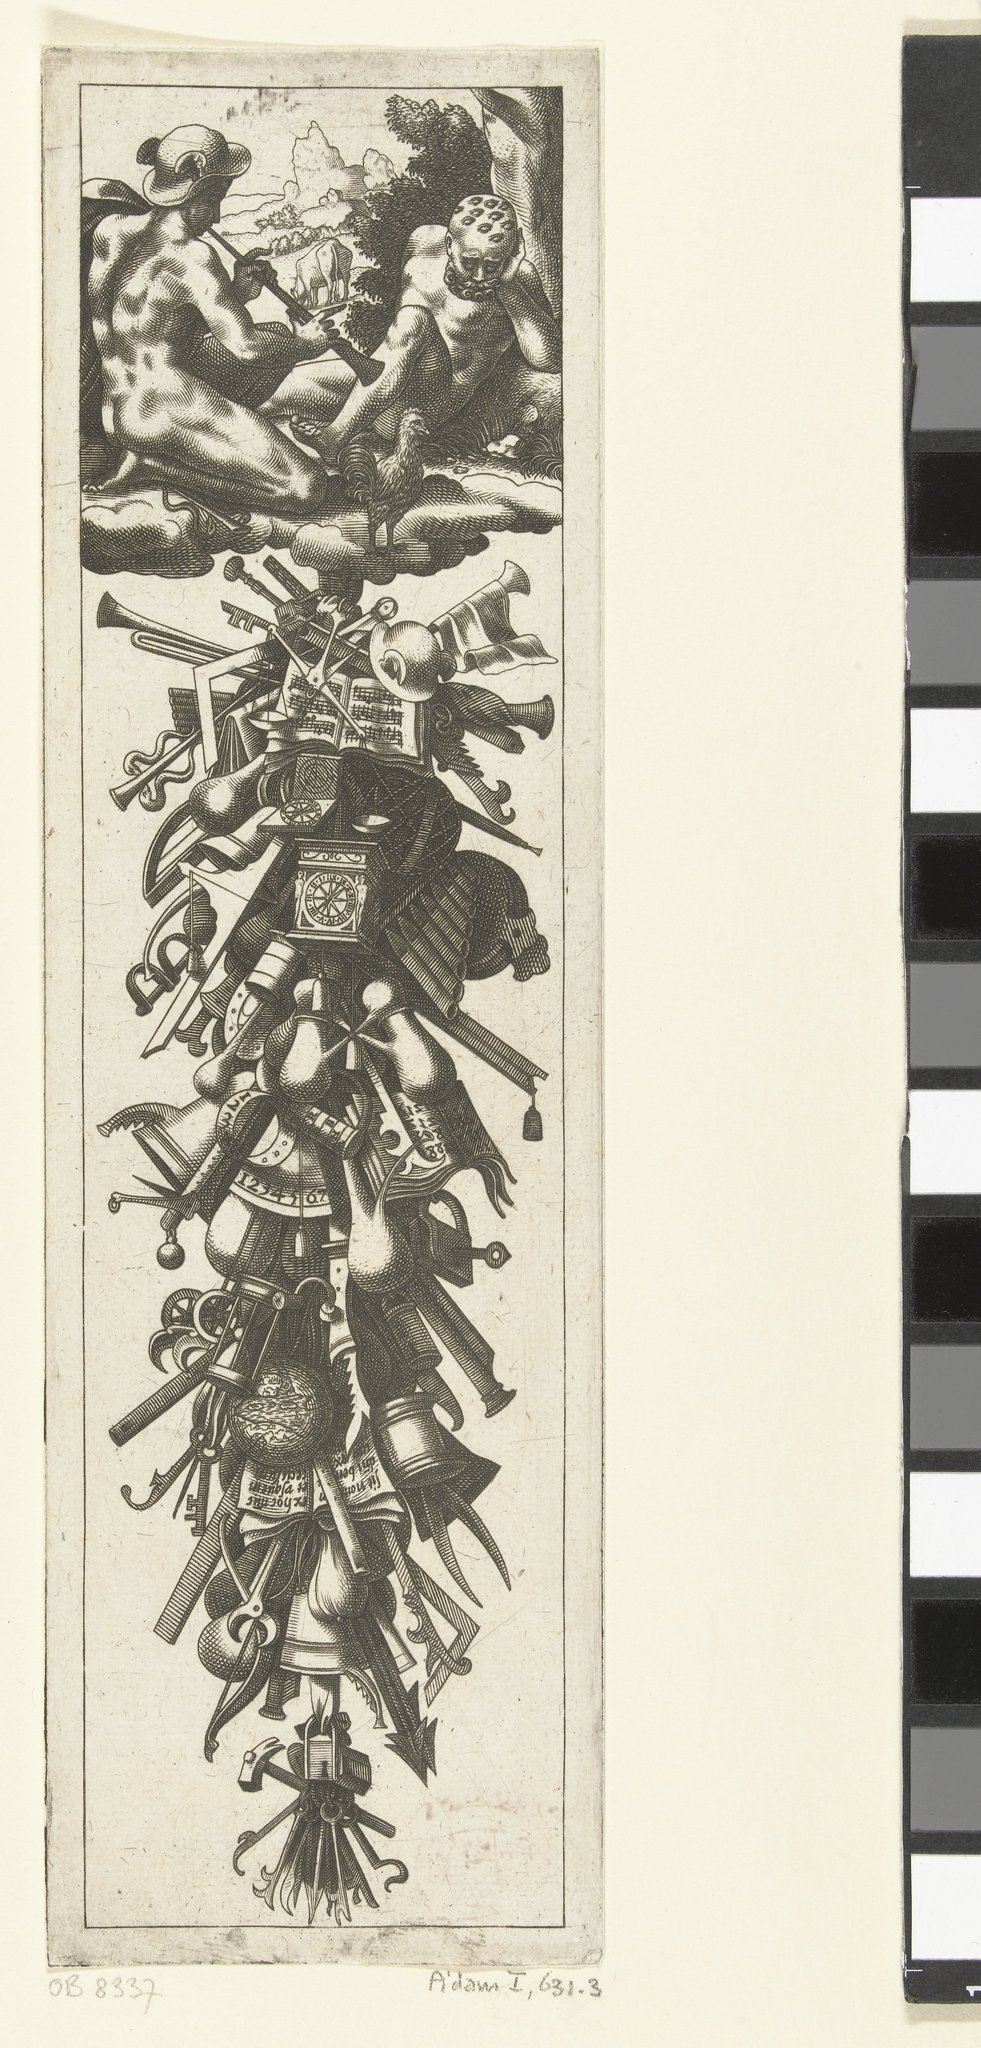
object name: ornament print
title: Trofee van muziek- en wetenschappelijke instrumenten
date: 1551-1580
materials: paper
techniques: engraving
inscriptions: collector's mark: Lugt 240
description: Op de wolk zit Mercurius die Argus in slaap speelt.